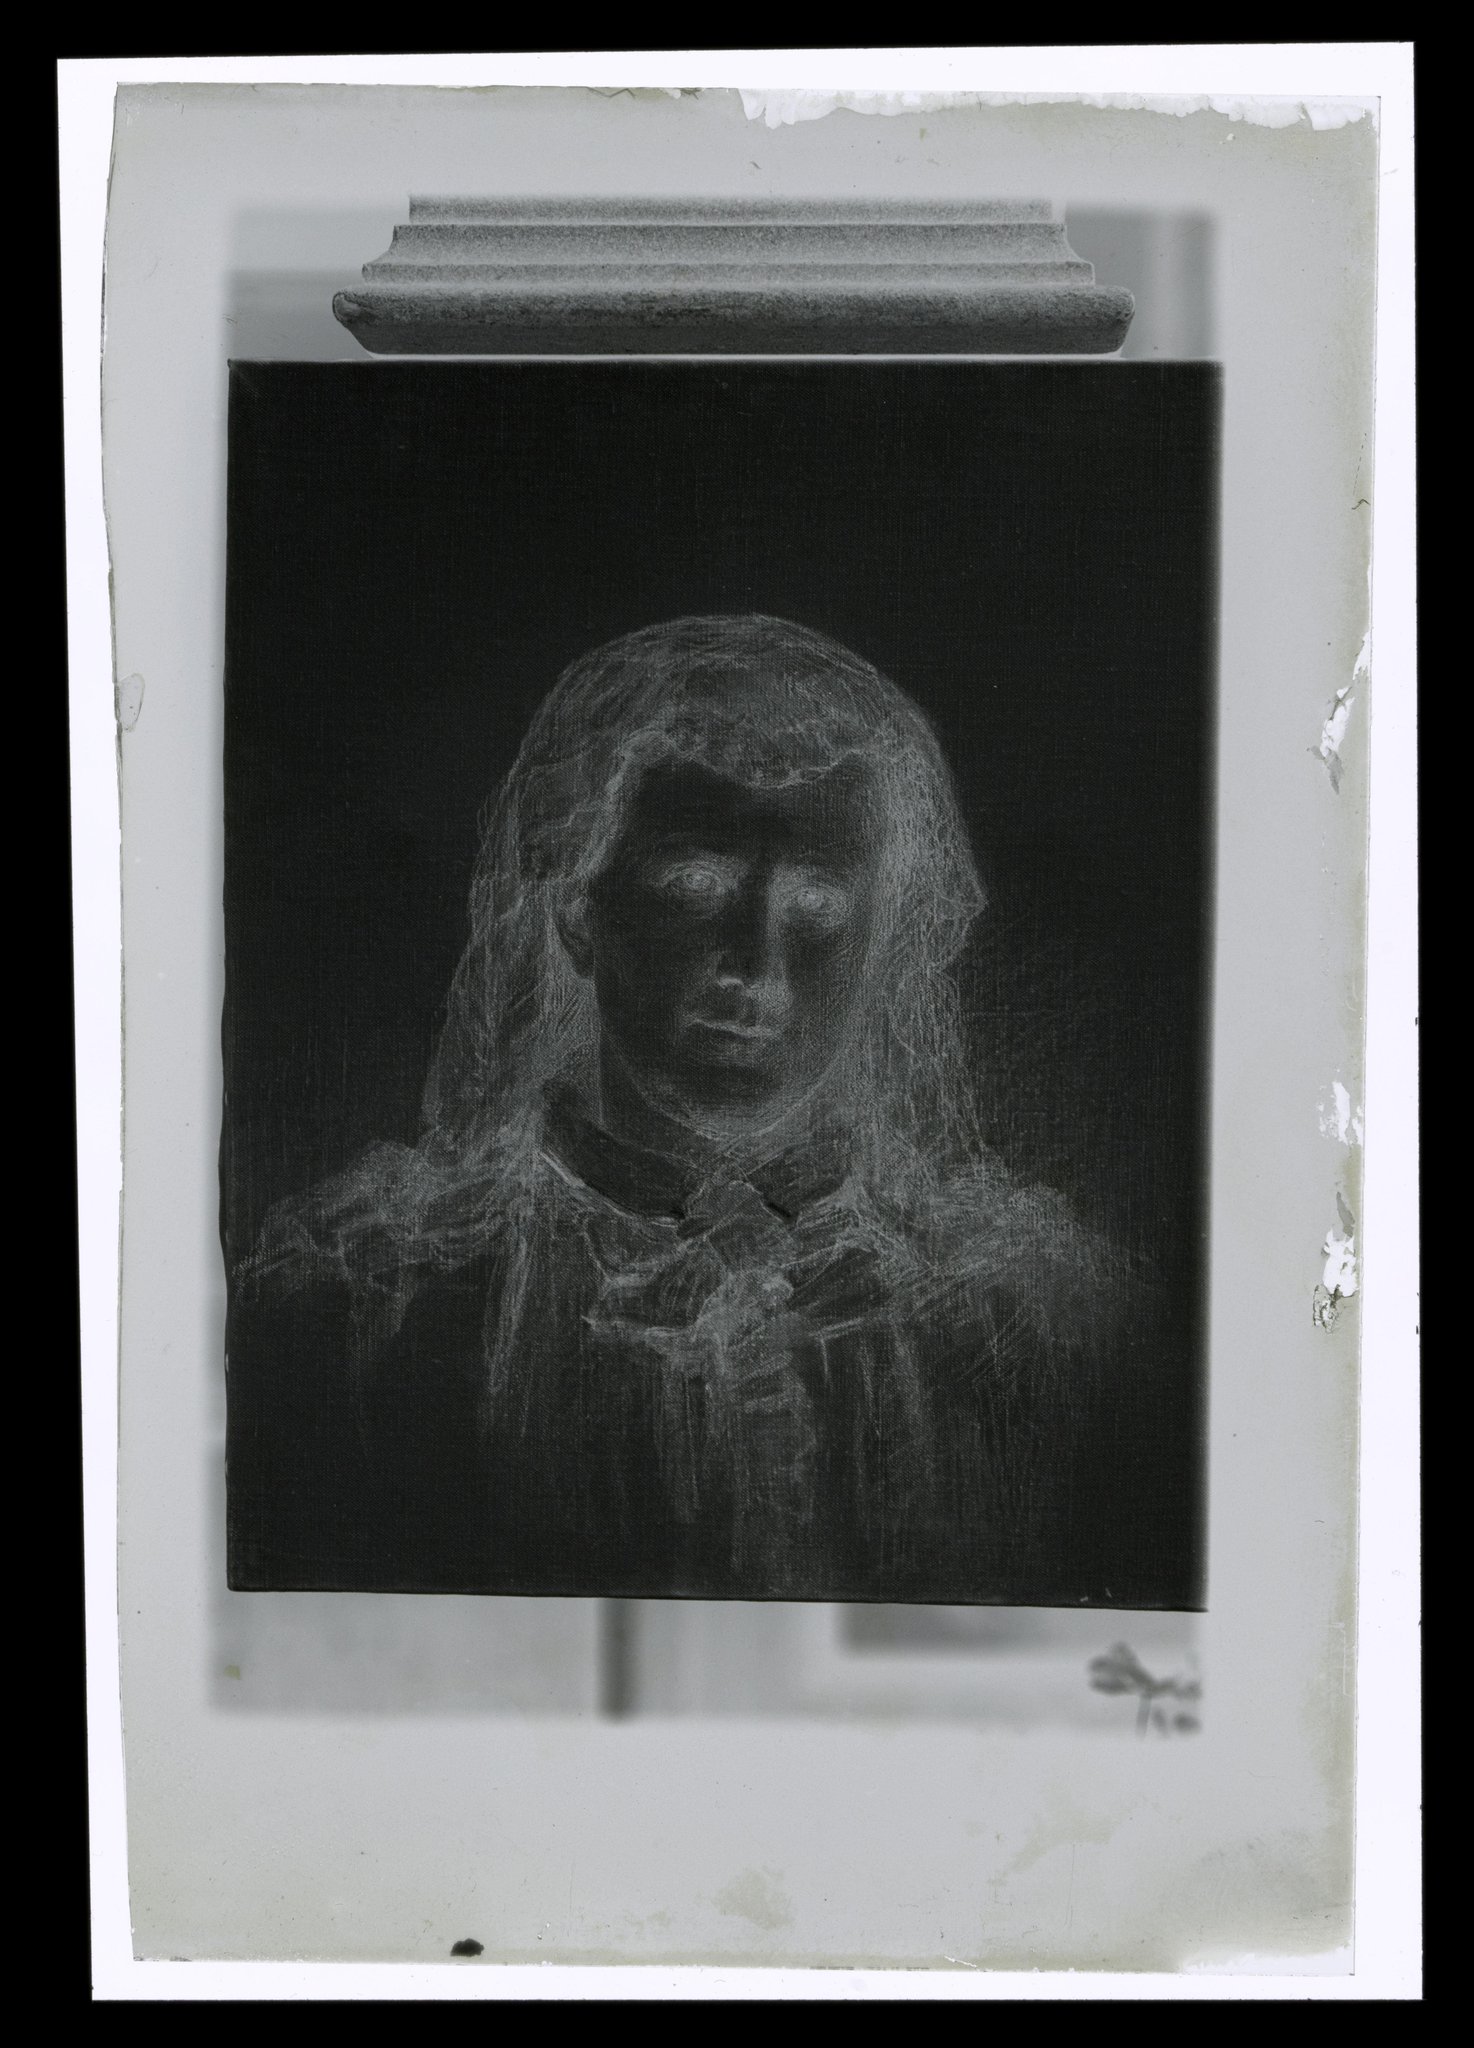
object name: reproduction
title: Fotoreproductie van een getekend portret van een onbekende vrouw met pruik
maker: laurens lodewijk kleijn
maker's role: draughtsman, painter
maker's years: 1826-1909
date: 1865-1900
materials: glass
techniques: collodion process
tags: drawing, historical persons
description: Onderdeel van groep glasnegatieven uit de nalatenschap van de schilder Laurens Lodewijk Kleijn, stillevens, portretten, zelfportretten en kunstreproducties.